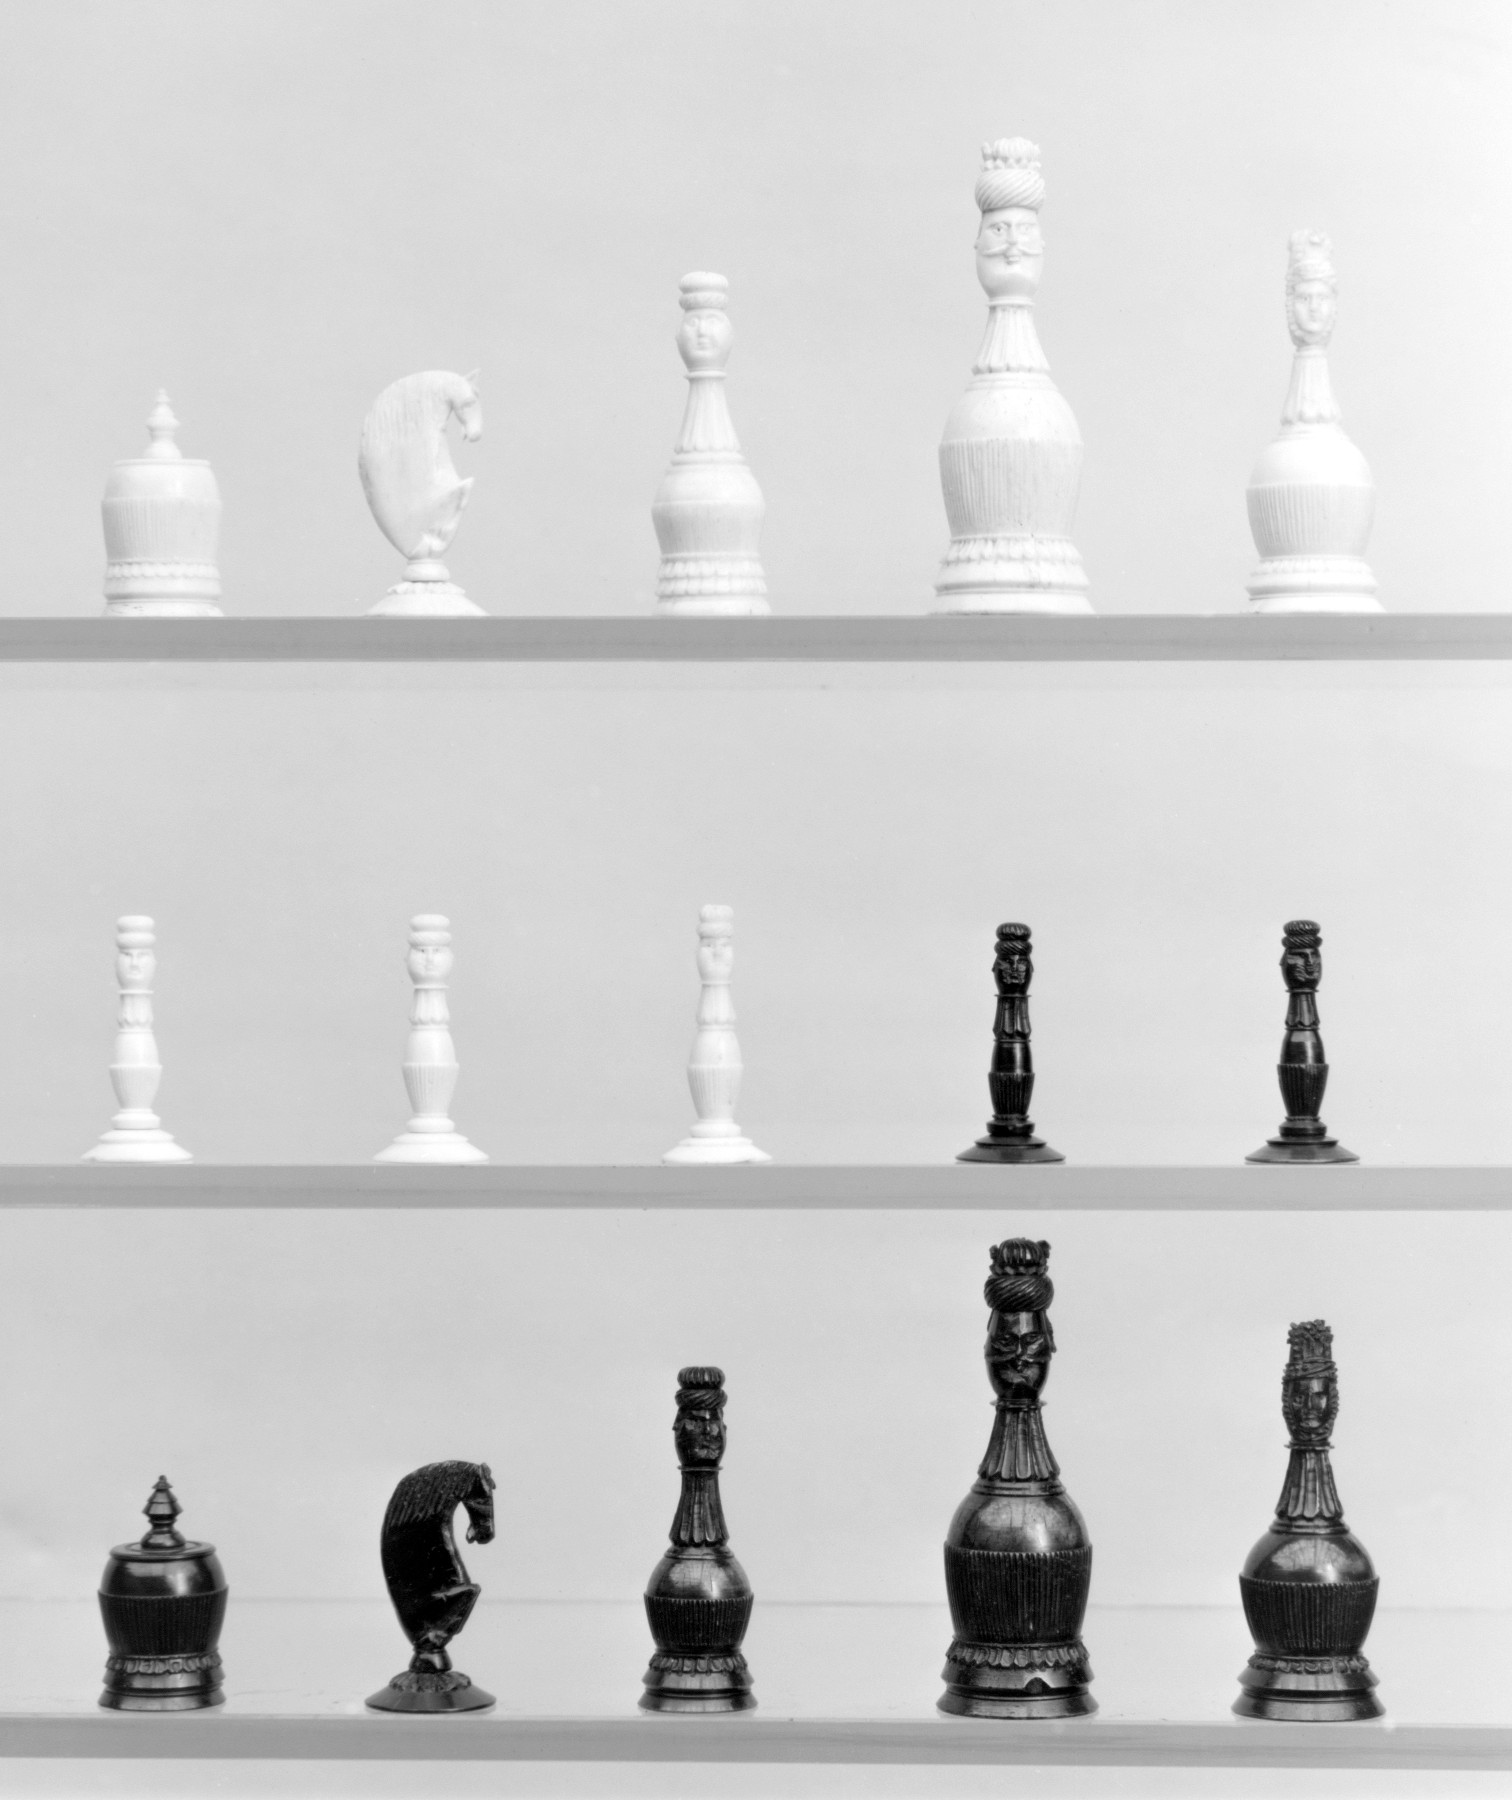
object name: chessman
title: Chessmen (32)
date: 1801-1900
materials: horn, ivory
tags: chess,games